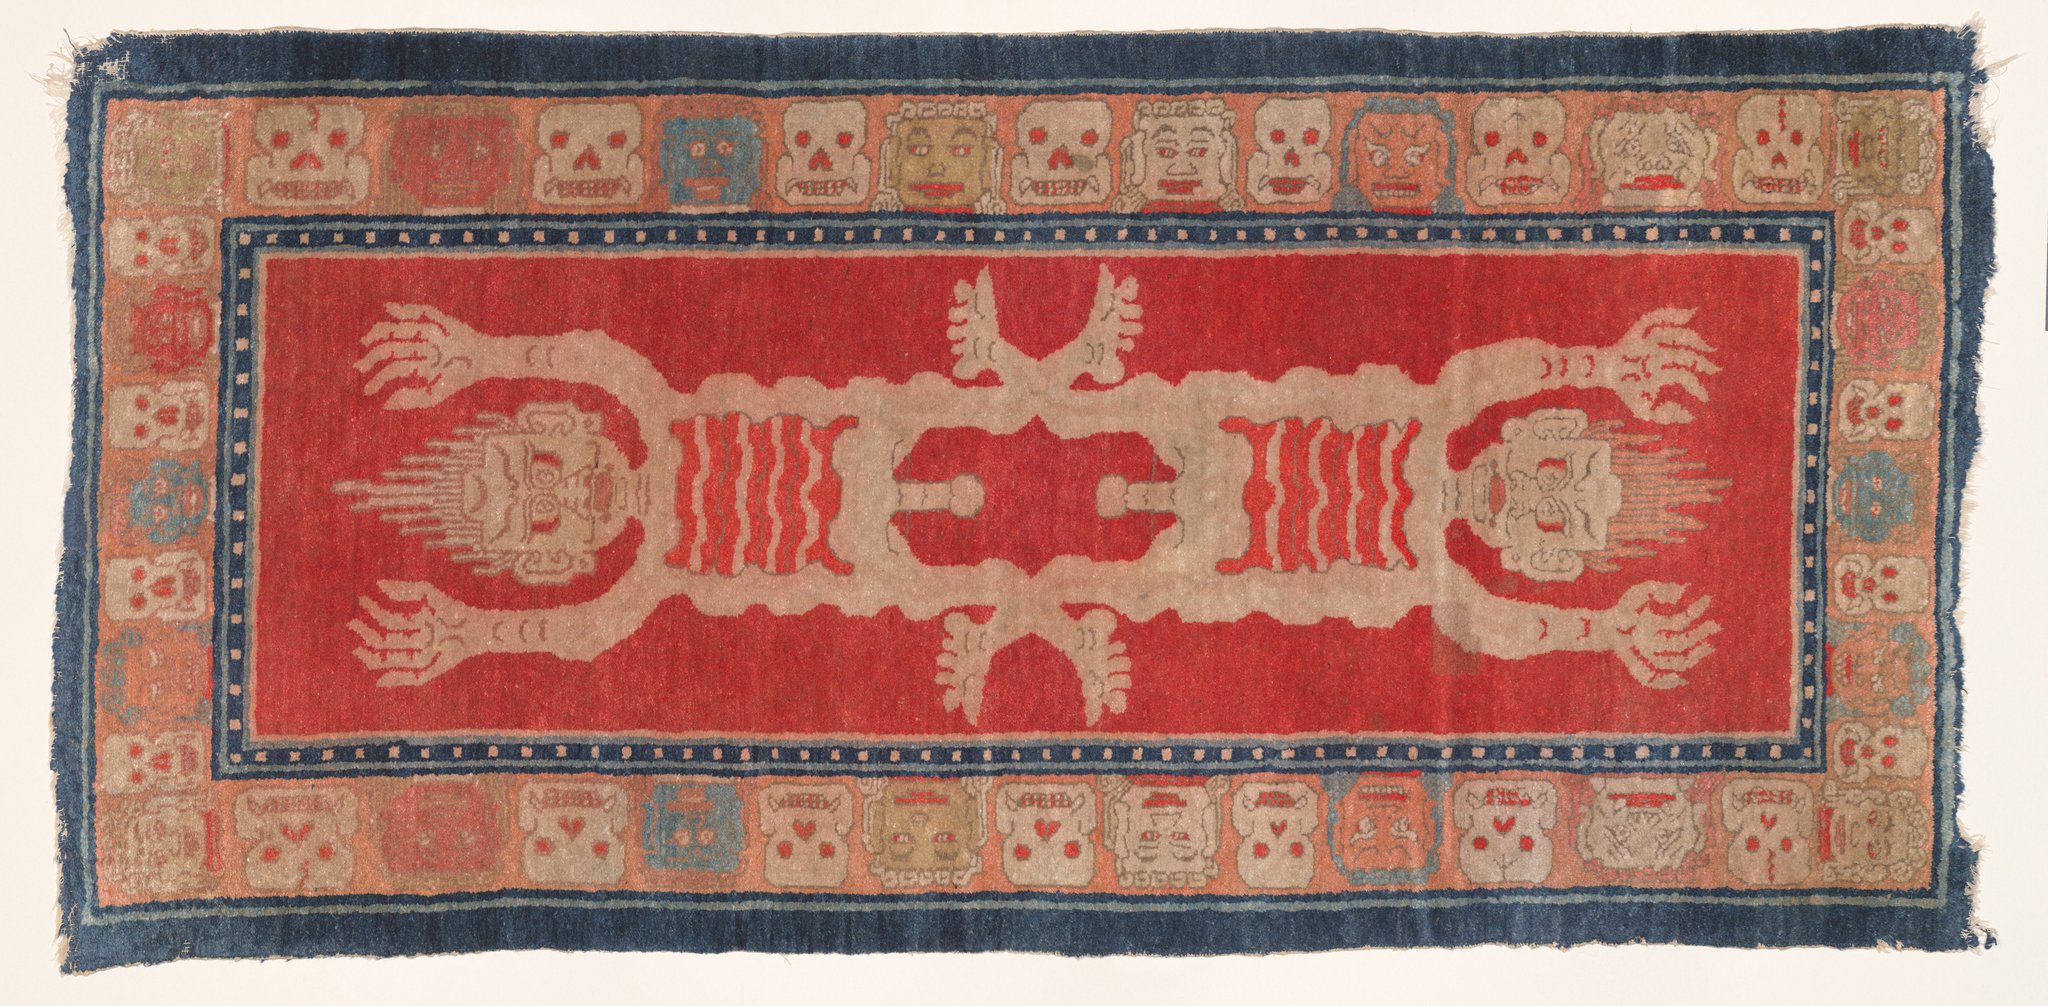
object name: rug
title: Tantric Rug with Two Flayed Male Figures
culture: tibetan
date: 1701-1900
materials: cotton, dye, wool